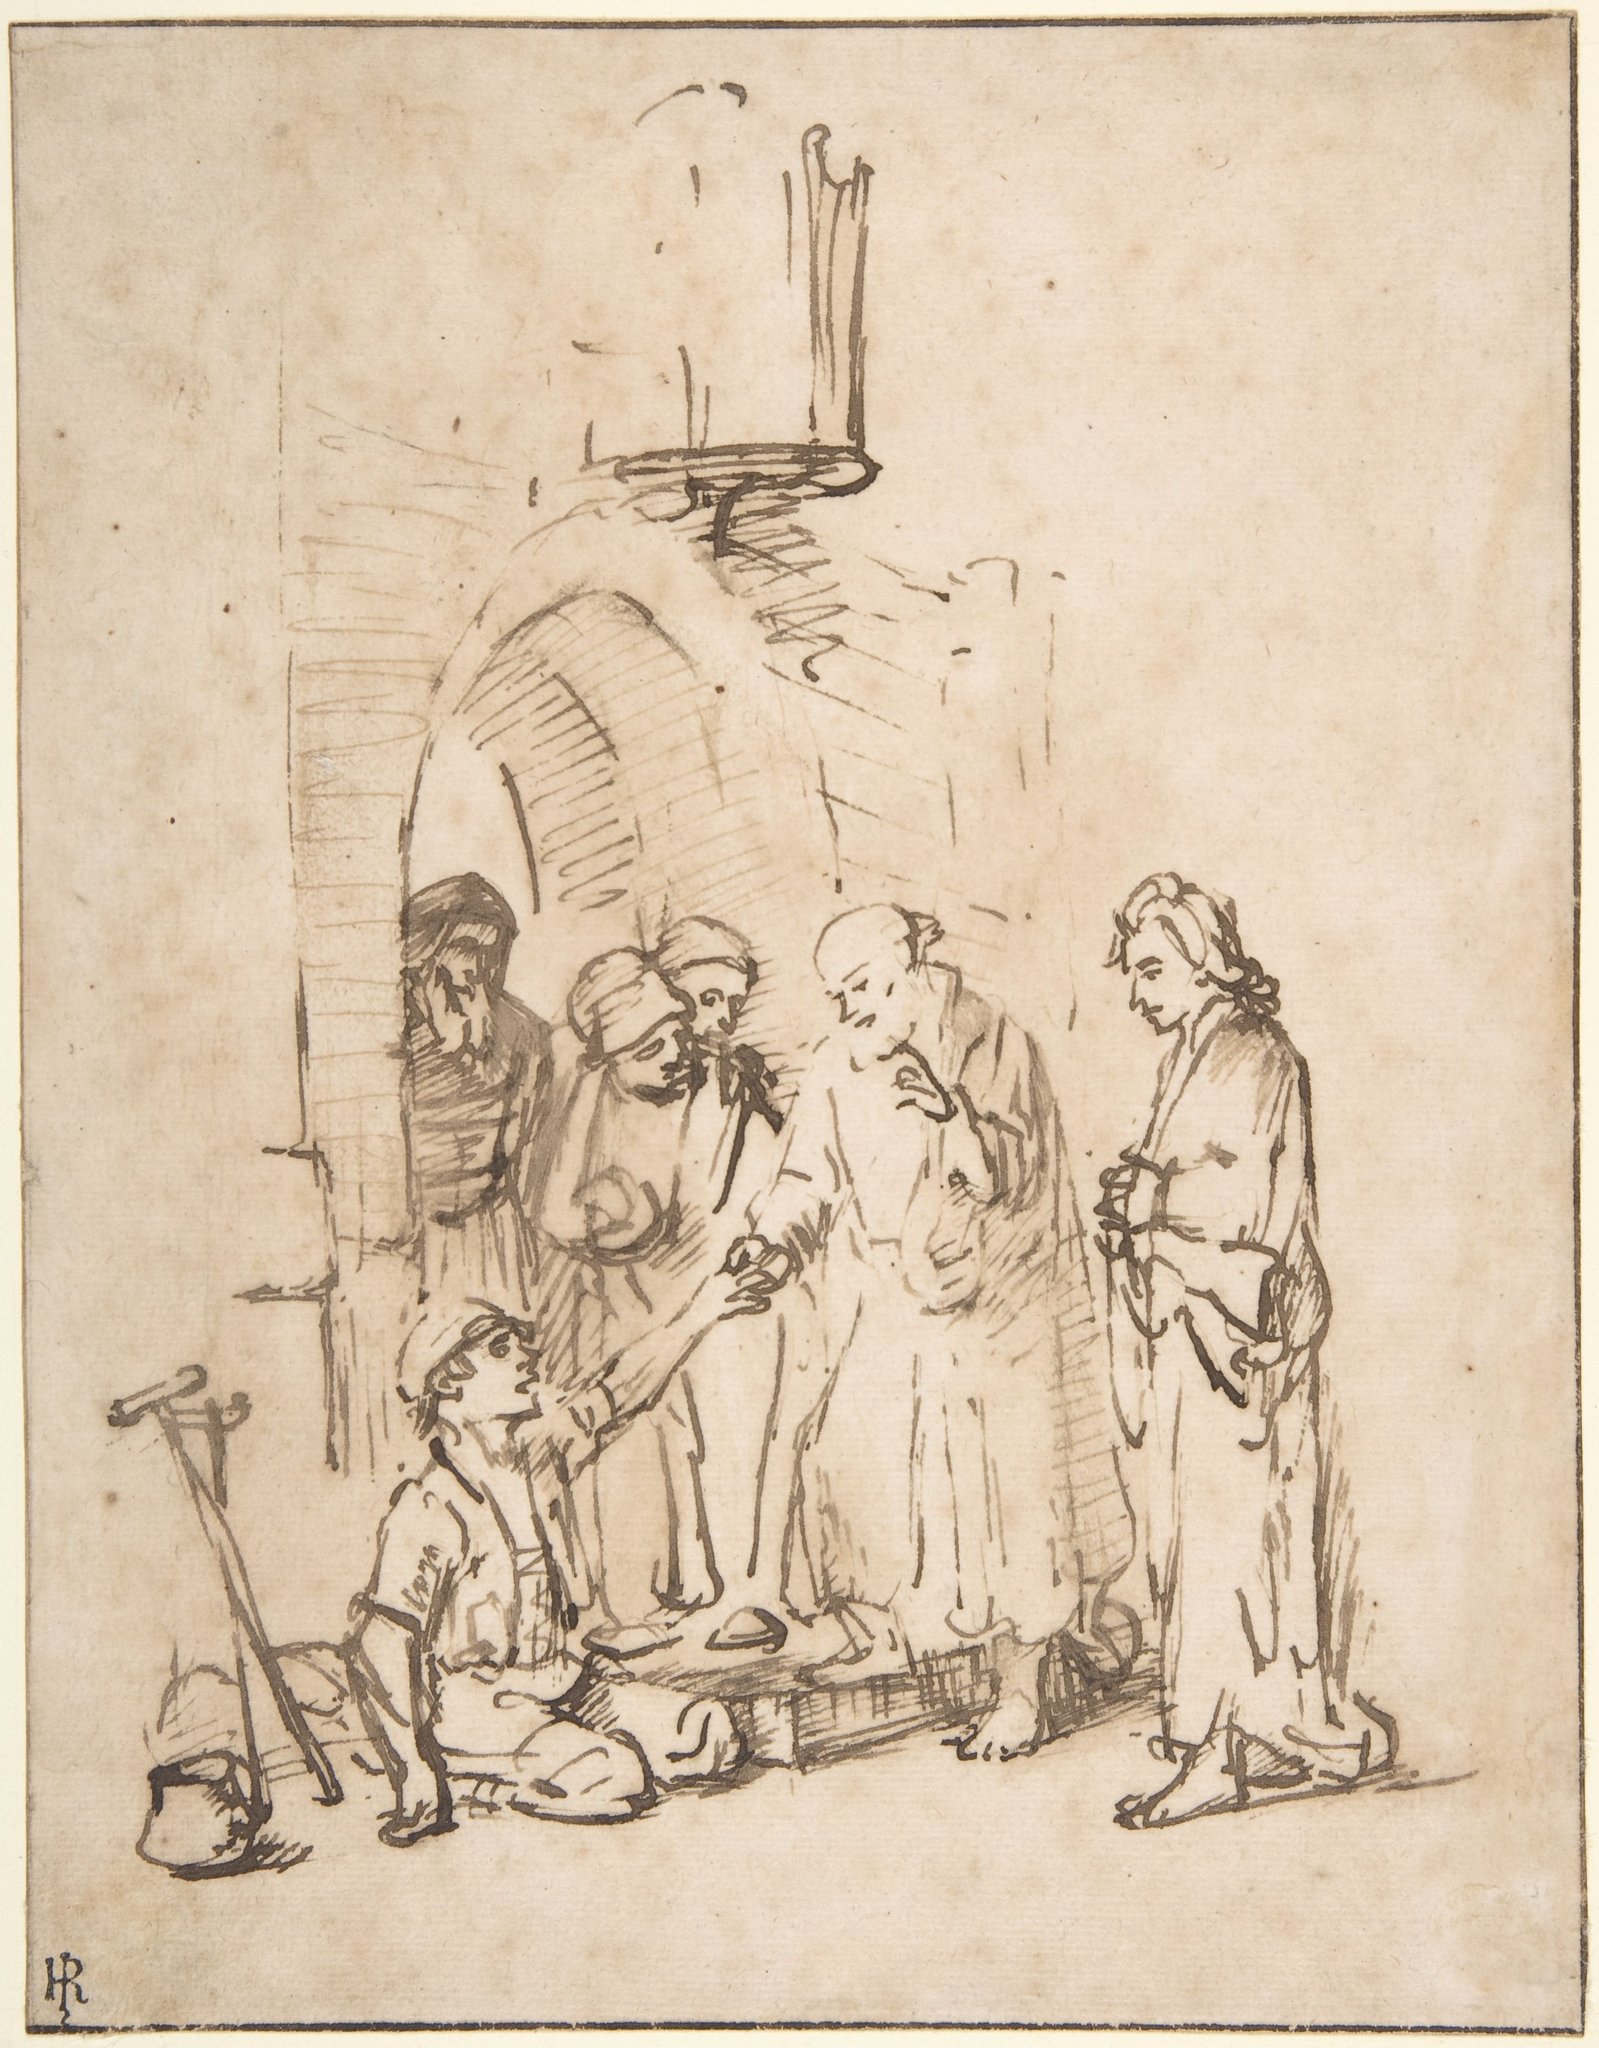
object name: drawing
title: St. Peter and St John Healing the Paralytic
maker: rembrandt van rijn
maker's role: artist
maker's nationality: dutch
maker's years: 1606-1669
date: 1606-1669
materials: ink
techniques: brush, pen, wash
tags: men,saint peter,saints